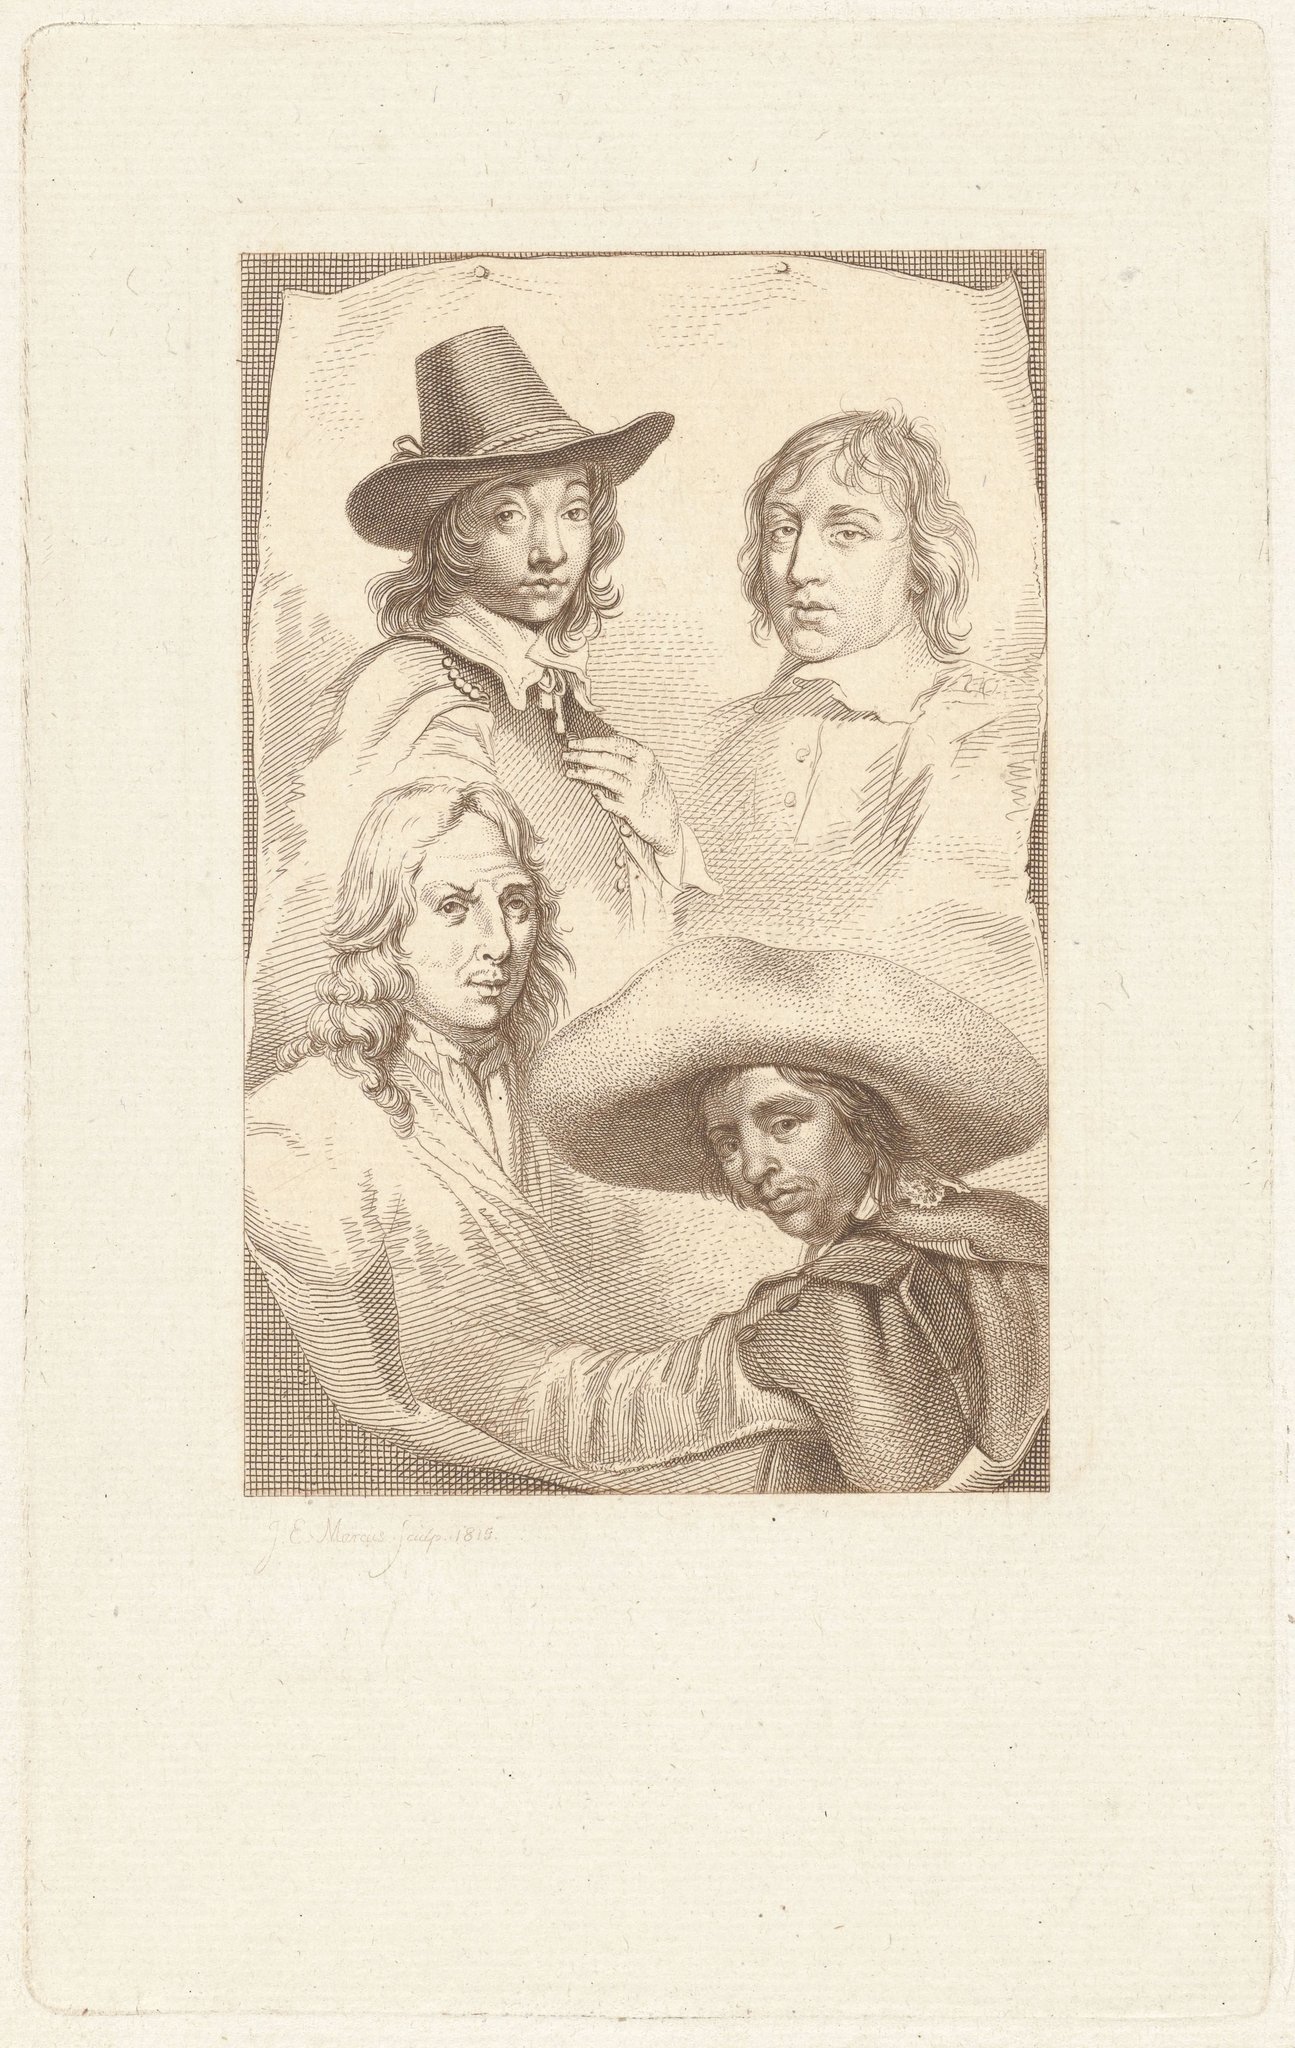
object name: print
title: Portretten van Cornelis Visscher, Jan de Visscher, Richard Brakenburg en Quiringh Gerritsz. van Brekelenkam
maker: jacob ernst marcus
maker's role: draughtsman, print maker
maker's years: 1774-1826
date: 1815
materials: paper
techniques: etching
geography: amsterdam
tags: haarlem, print maker, richard brakenburg, jan de visscher, leiden, draughtsman, quiringh gerritsz. van brekelenkam, cornelis visscher (ii)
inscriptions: collector's mark: Lugt 2228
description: Latere staat van de prent gebruikt in: Roeland van Eynden, Adriaan van der Willigen, Geschiedenis der vaderlansche schilderkunst, sedert de helft der XVIII eeuw. Haarlem, A. Loosjes, Pz [vanaf dl 3: Wed. A. Loosjes], 4 dln., 1816-40.